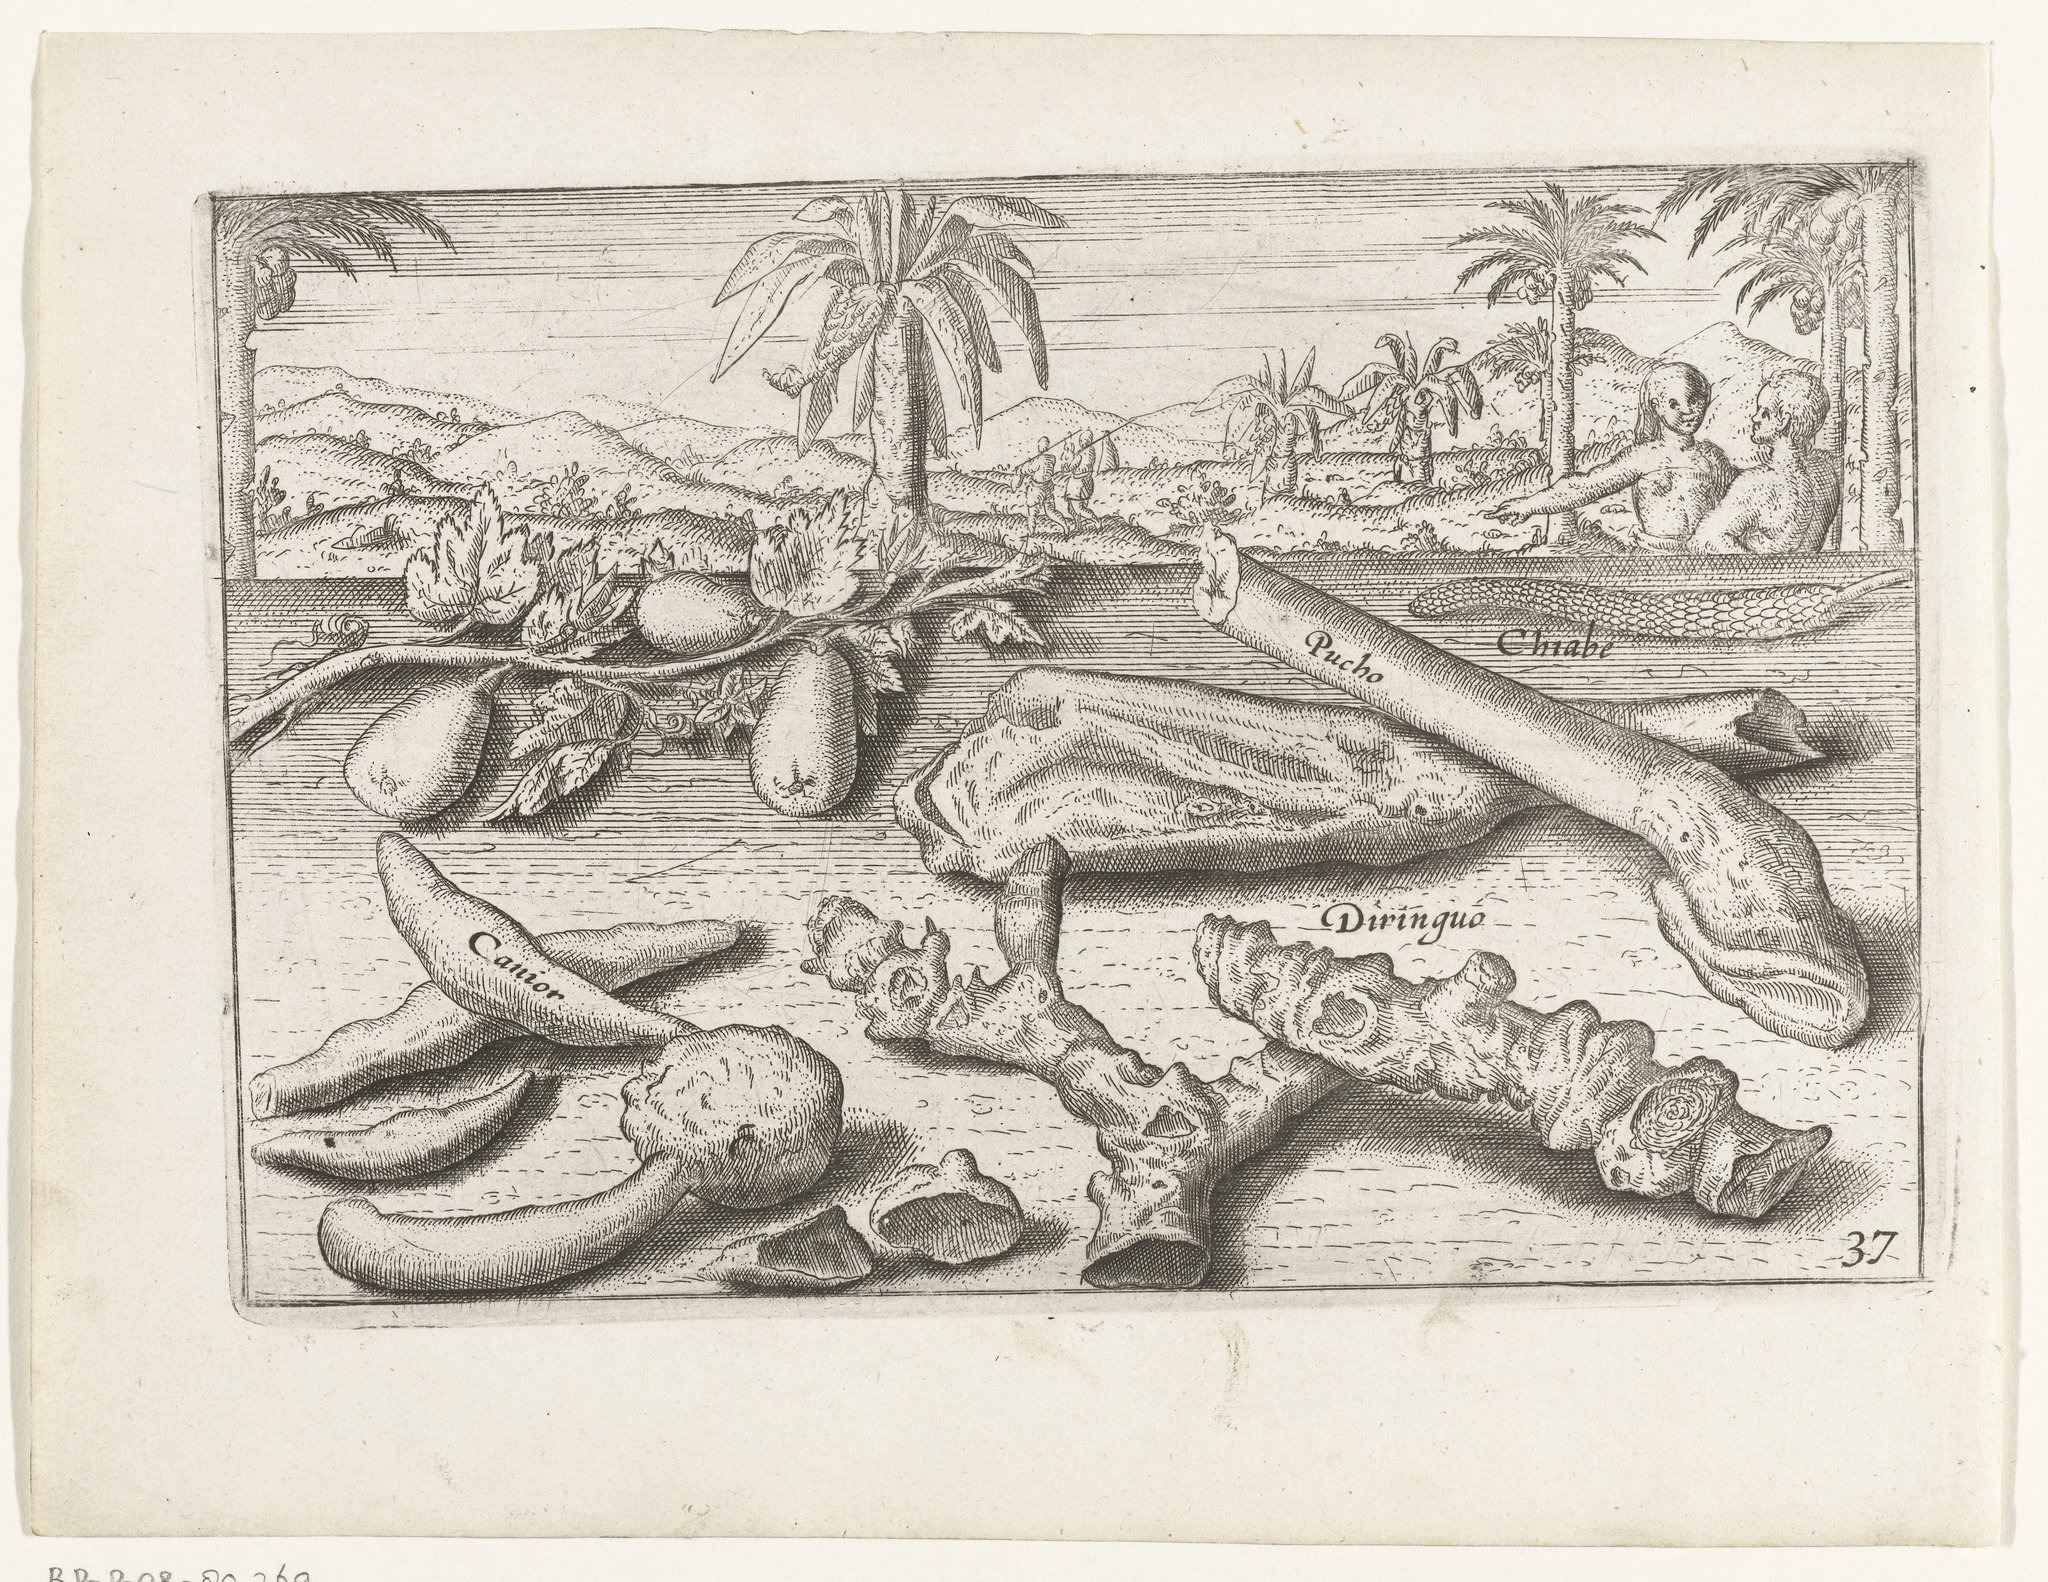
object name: print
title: Kruiden en knolgewassen op Java, 1596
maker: Anonymous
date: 1597-1598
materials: paper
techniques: engraving, etching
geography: northern netherlands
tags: gouda, plants; vegetation, landscapes in tropical and sub-tropical regions, exploration, expedition, voyage of discovery, java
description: Gebruikt als illustratie eerst in: Willem Lodewijcksz, D'eerste boeck. Historie van Indien, waer inne verhaelt is de avontueren die de Hollandtsche schepen bejeghent zijn, Cornelis Claes, Amsterdam 1598. In deze opgewerkte staat gebruikt in: De Eerste Schipvaerd der Hollandsche Natie naer Oost-Indien, waer inne verhaelt wordt al wat haer sonderlings onder wegen bejegent is ... ghetrocken uyt verscheyden Iournalen ofte dagh-registers daer van ghemaeckt, zeer vermaeckelijck ende nut om lesen. Opgenomen in: I. Commelin, Begin ende voortgangh, van de Vereenighde Nederlantsche Geoctroyeerde Oost-Indische Compagnie, J. Janssonius, Amsterdam 1646. Genummerd: 37.